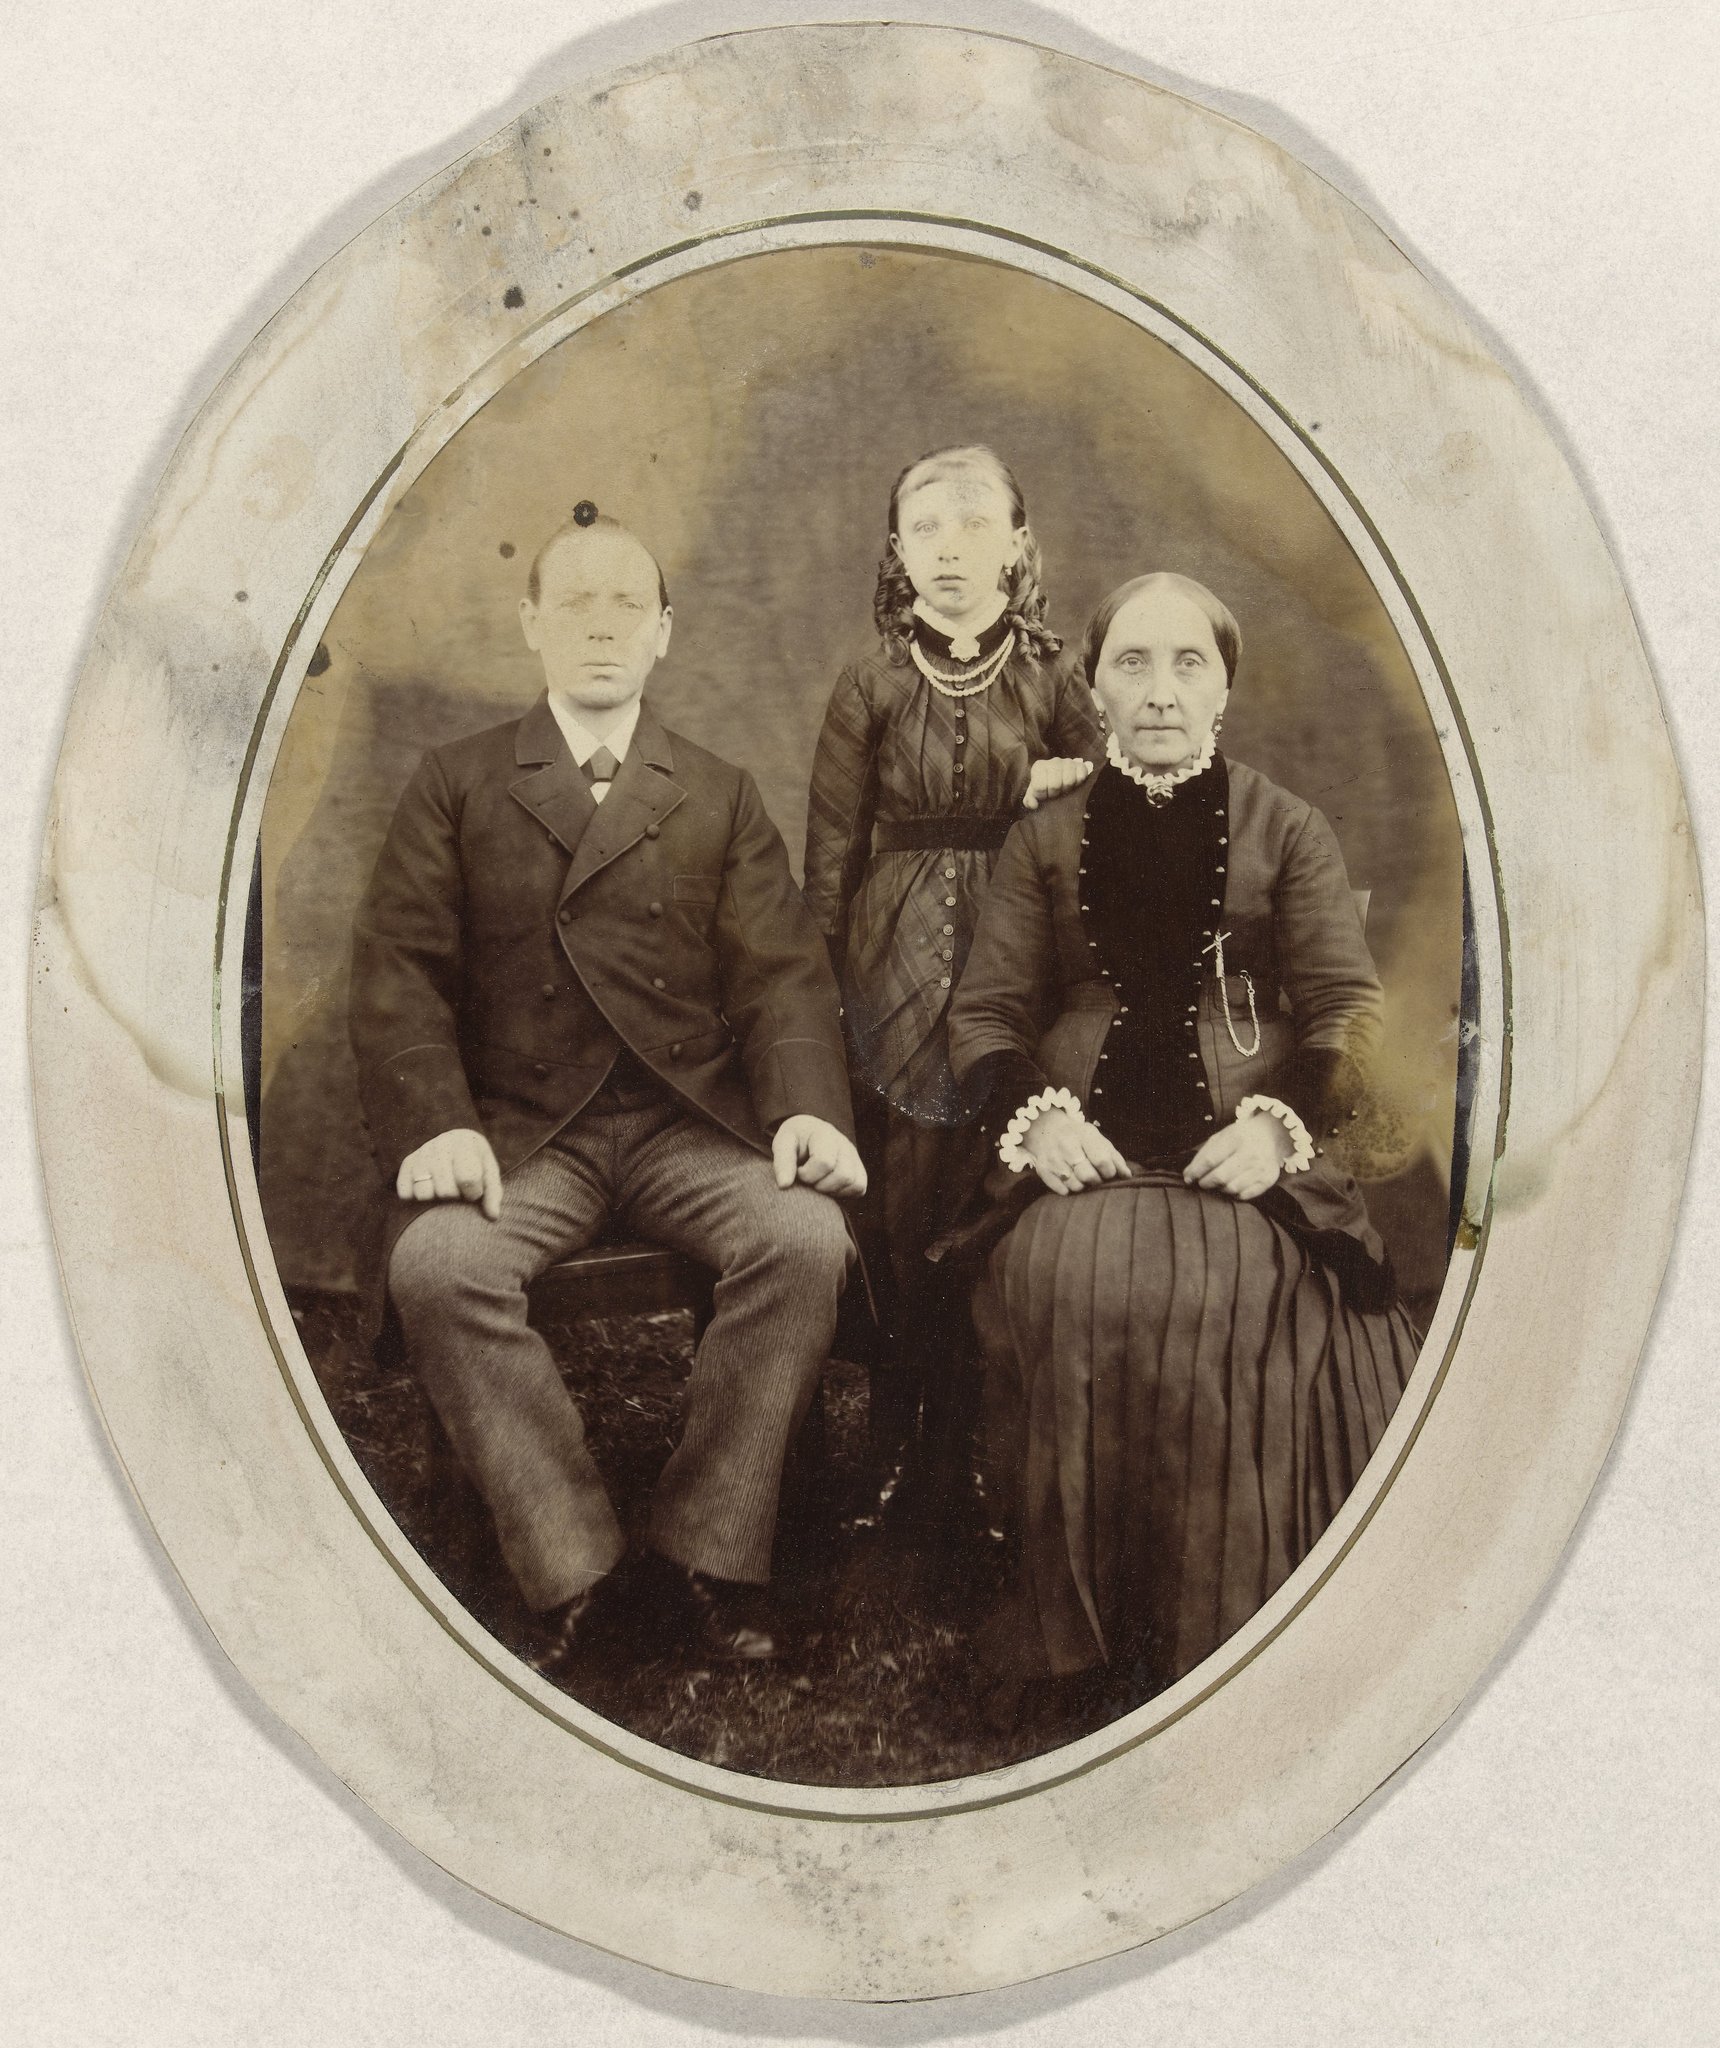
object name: photograph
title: Gezinsportret van een zittende man en vrouw met een staand meisje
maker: Anonymous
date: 1870-1890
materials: cardboard, photographic support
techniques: albumen print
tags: family group, especially parents with their child(ren)